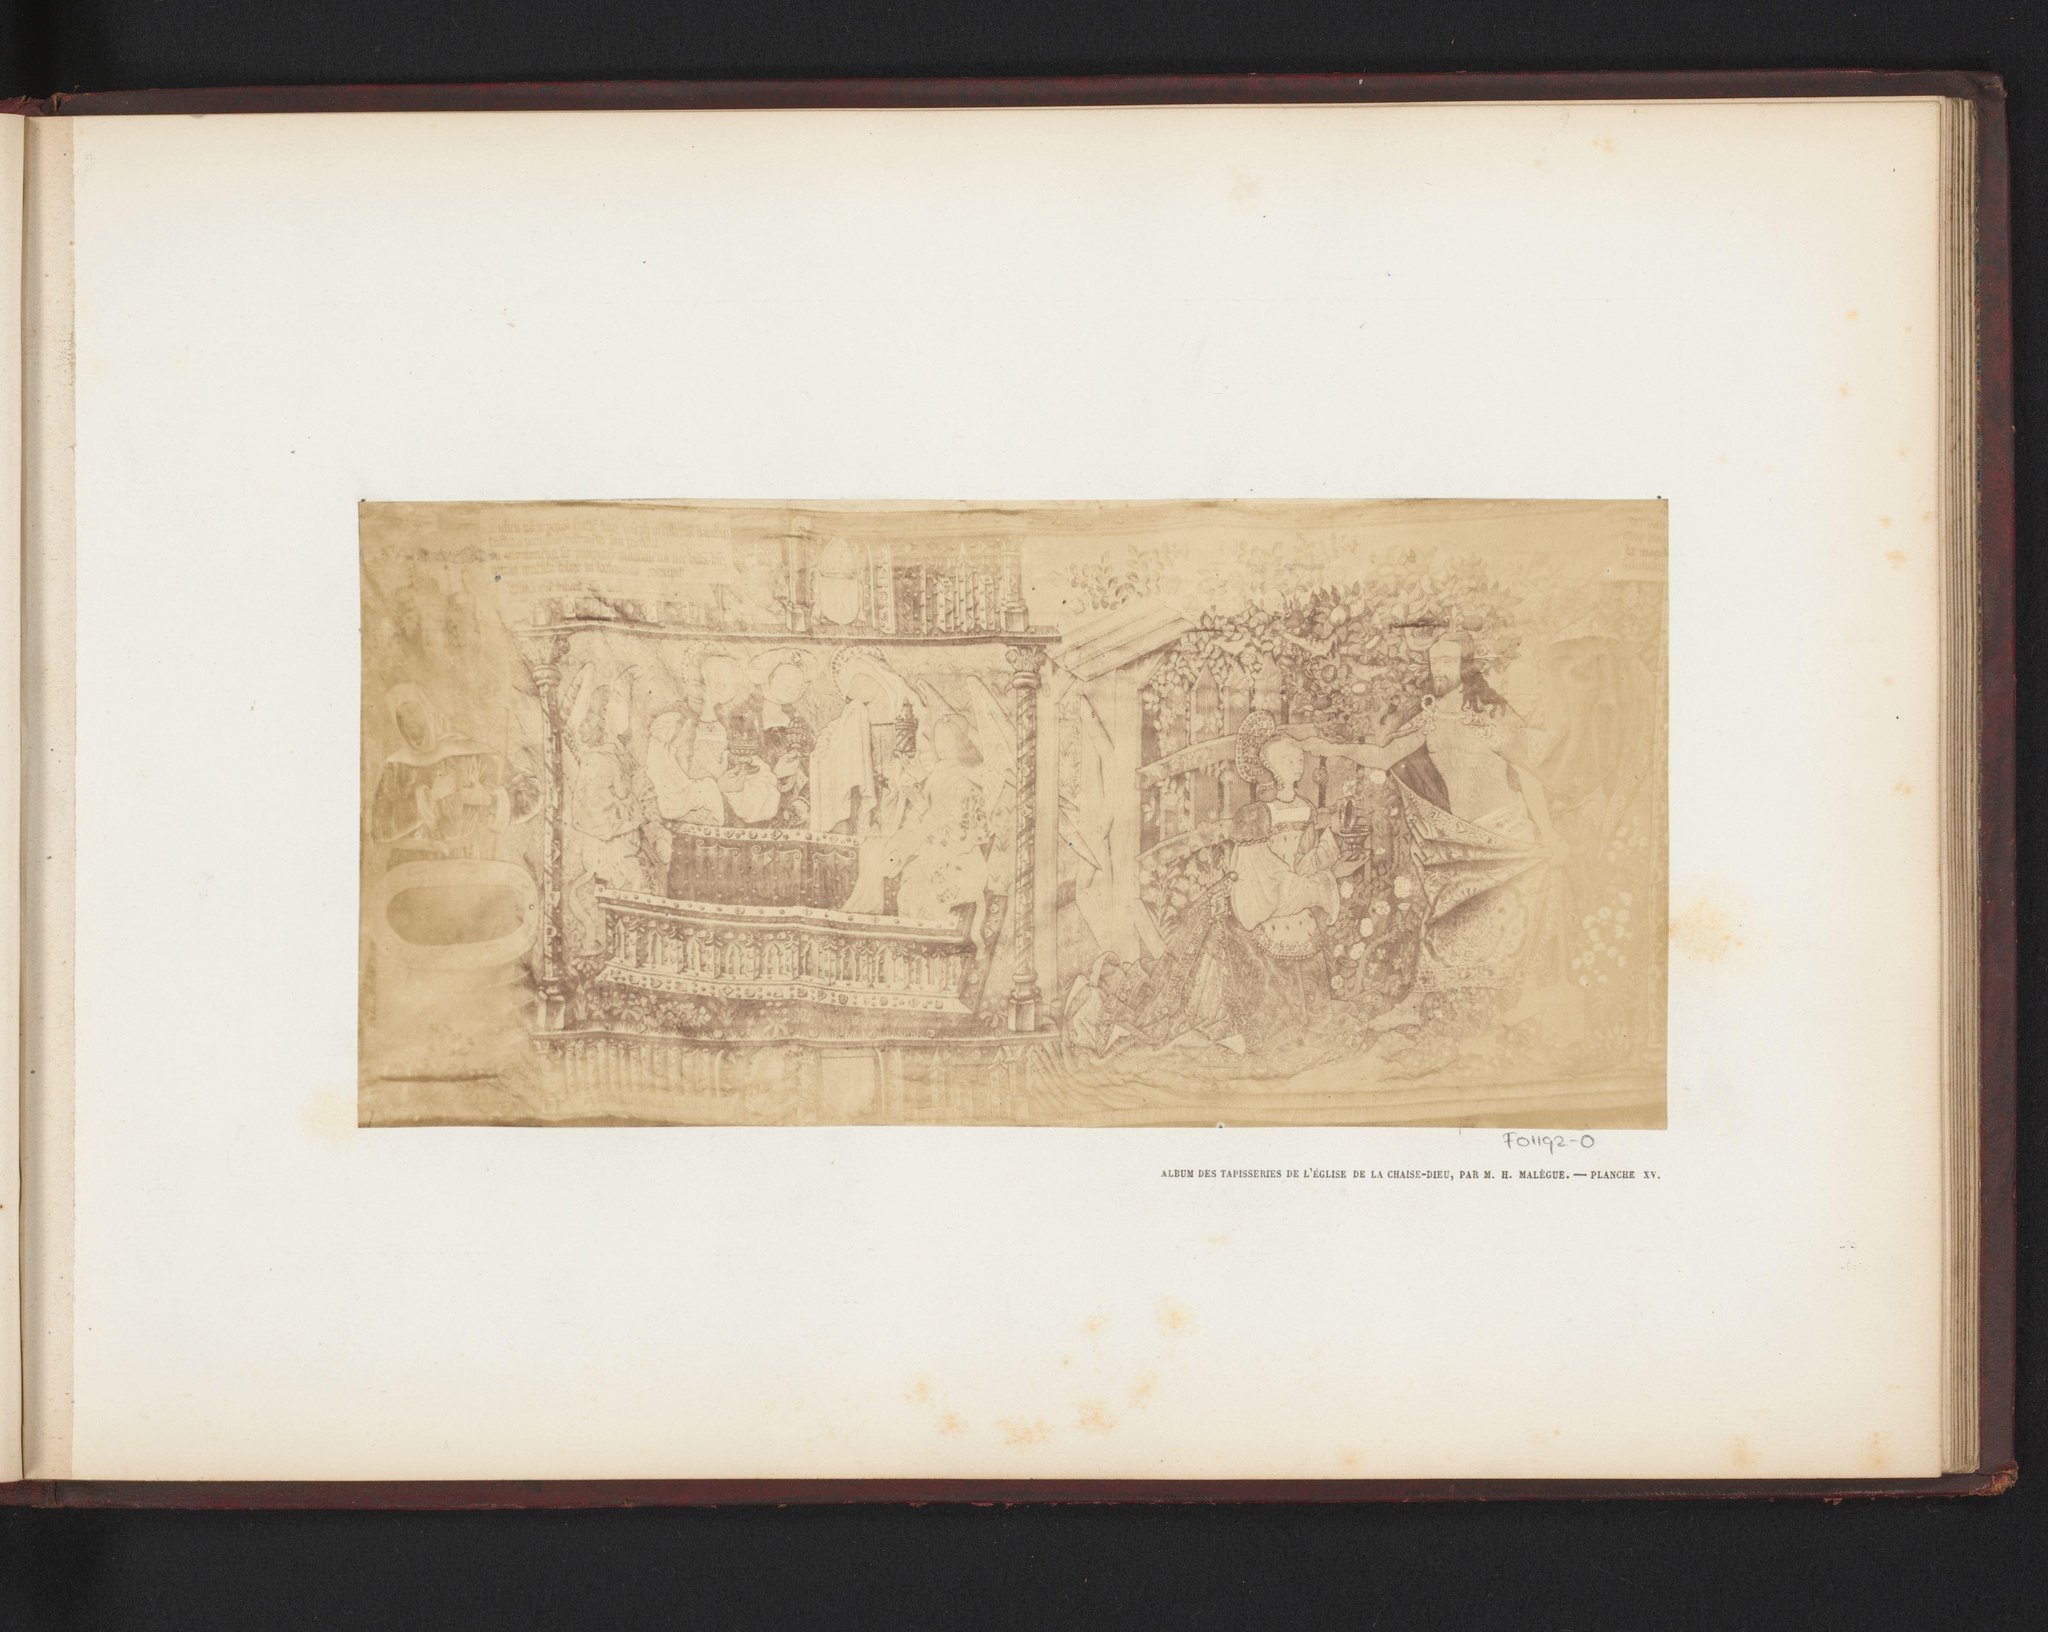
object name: photograph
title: Tapijt met Ruben en Jozef en wenende vrouwen bij Christus' graf in een kerk te La Chaise-Dieu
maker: hippolyte malègue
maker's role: archeoloog, fotograaf, schrijver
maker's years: 1825-1901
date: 1868-1873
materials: photographic support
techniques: albumen print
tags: tapestry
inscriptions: inscription: ‘album des tapisseries de l'église de la Chaise-Dieu, par M. H. Malegue - Planche XV’